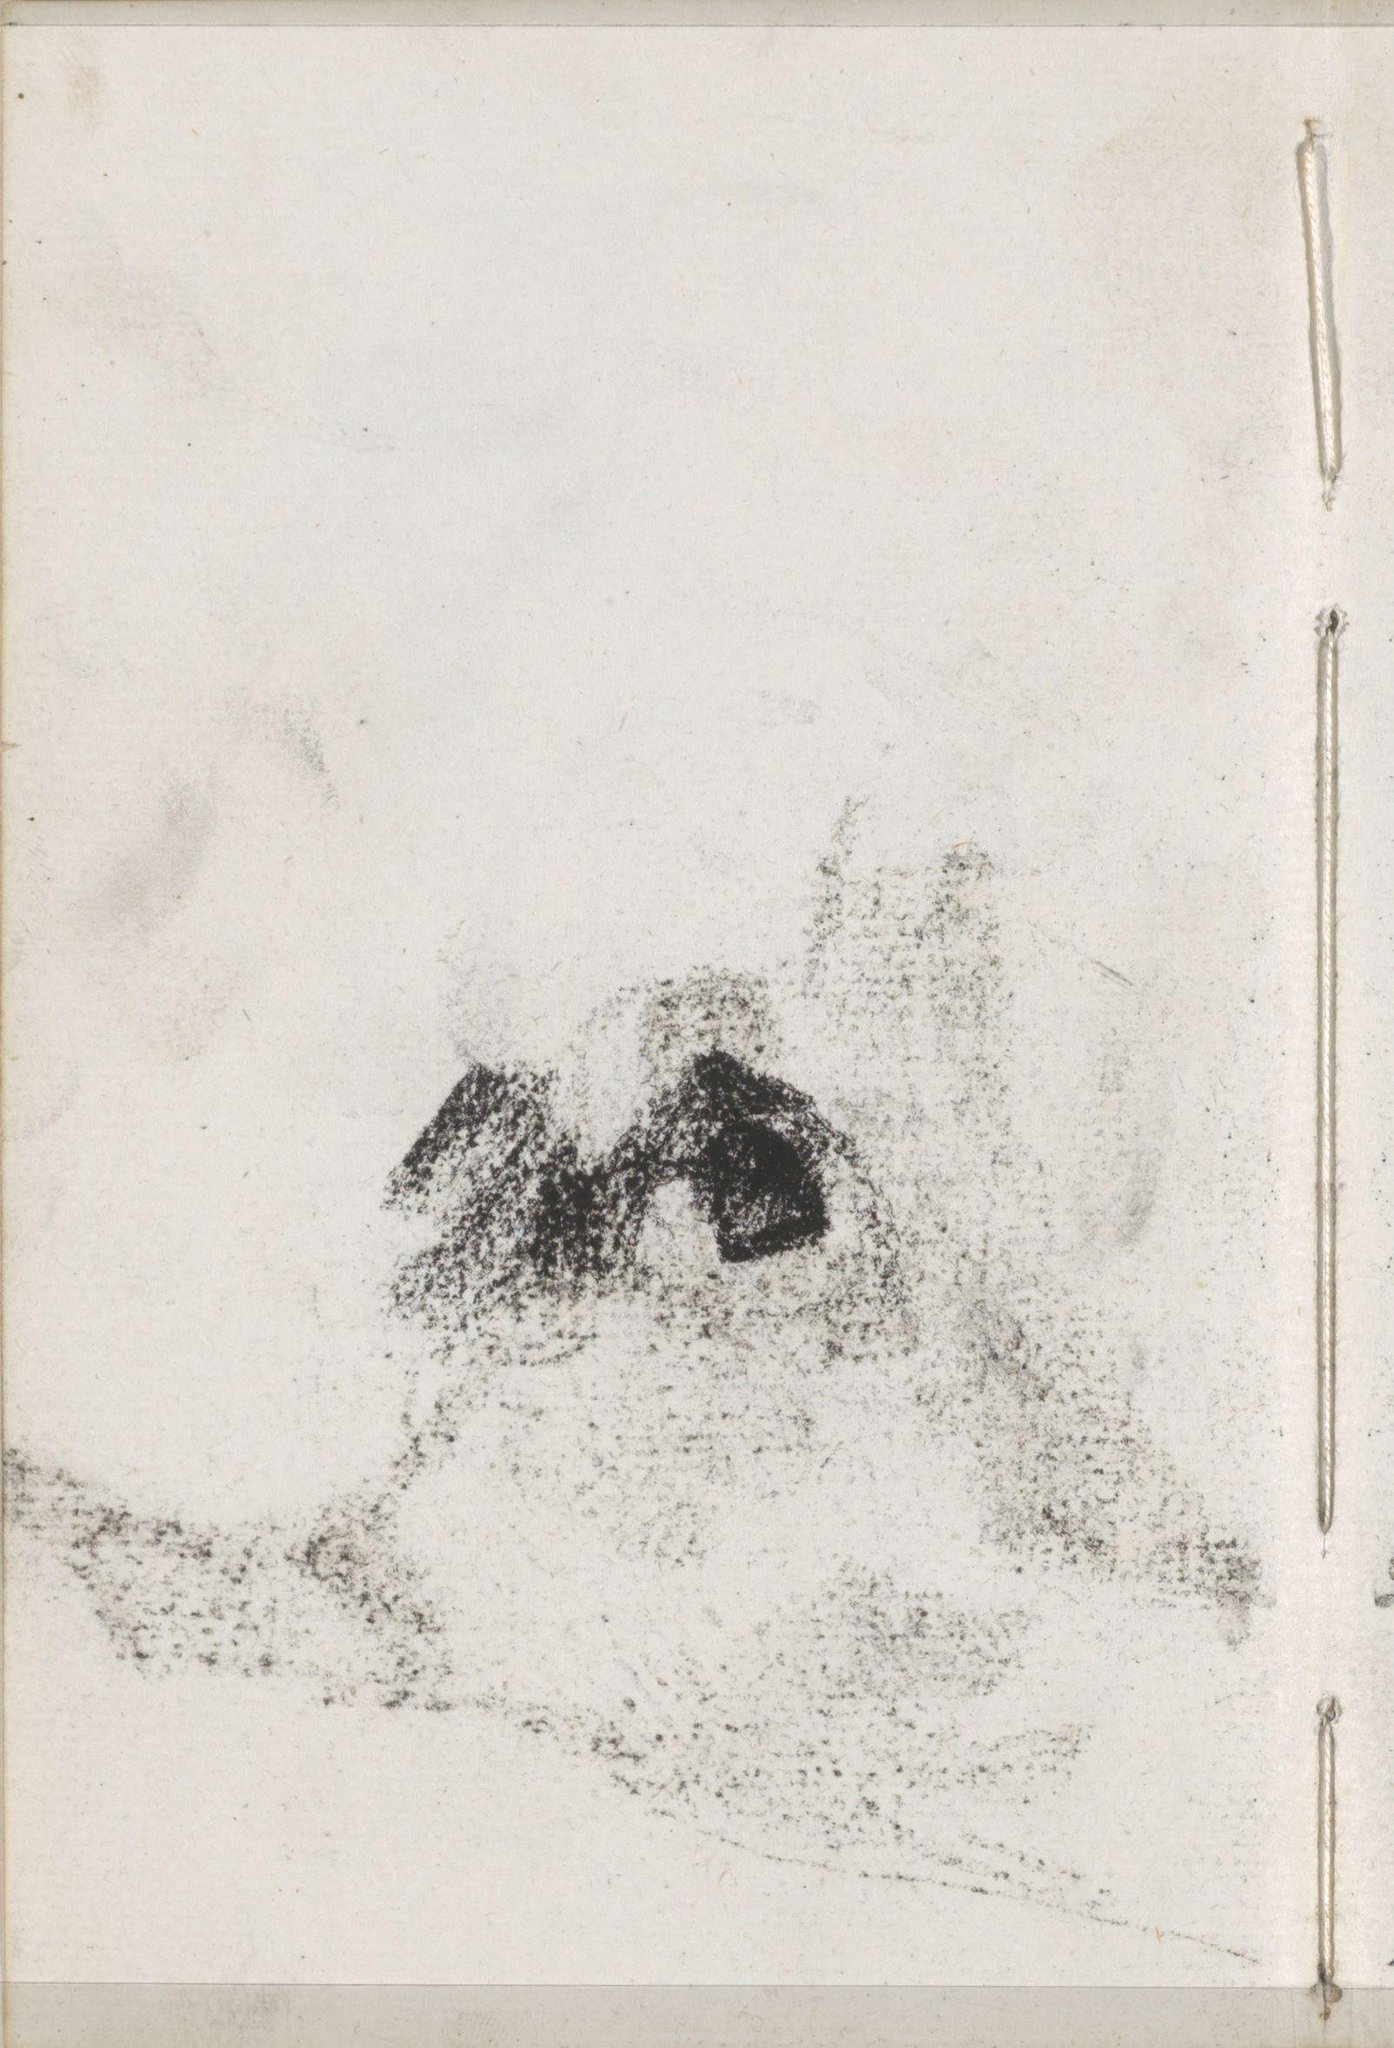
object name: sketchbook leaf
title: Studie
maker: george hendrik breitner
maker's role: draughtsman, painter, print maker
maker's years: 1857-1923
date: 1886-1895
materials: chalk, paper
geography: amsterdam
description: Pagina 15 uit een schetsboek met 20 bladen.